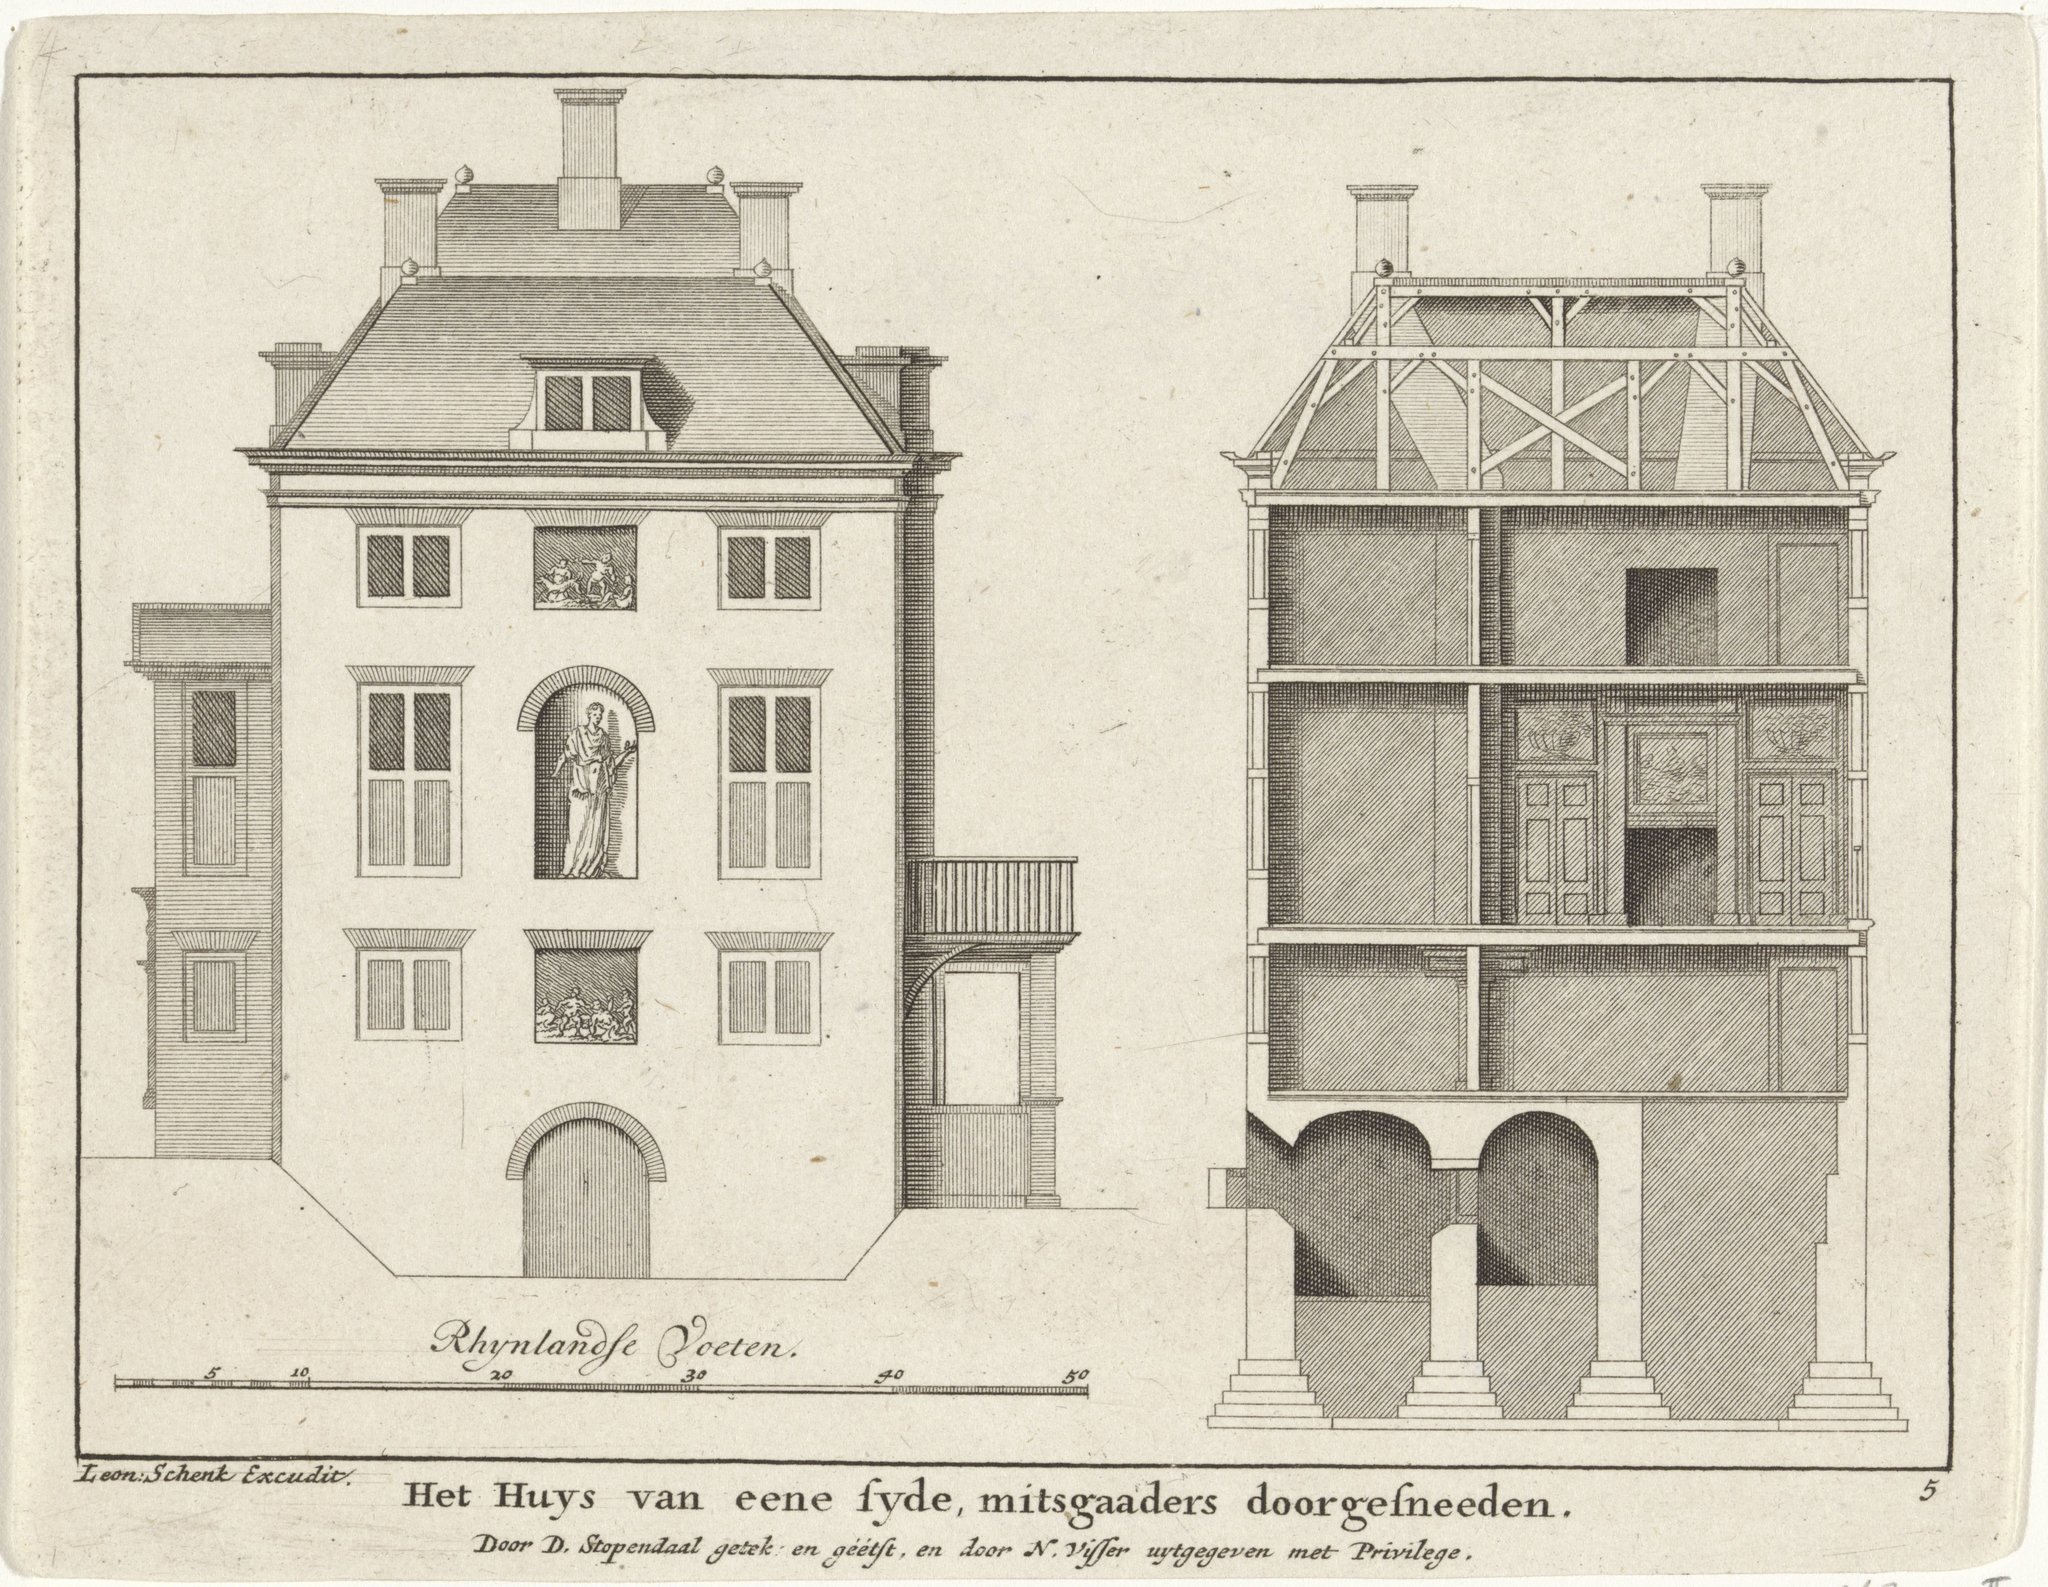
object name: print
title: Verscheyde schoone en vermaakelyke gezigten in de Hofstede van Clingendaal gelegen by 's Gravenhage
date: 1682-1726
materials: paper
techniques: etching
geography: amsterdam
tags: exterior ~ representation of a building, interior ~ representation of a building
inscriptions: collector's mark: Lugt 2228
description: Een zijaanzicht en een doorsnede van Huis Clingendael bij Den Haag.